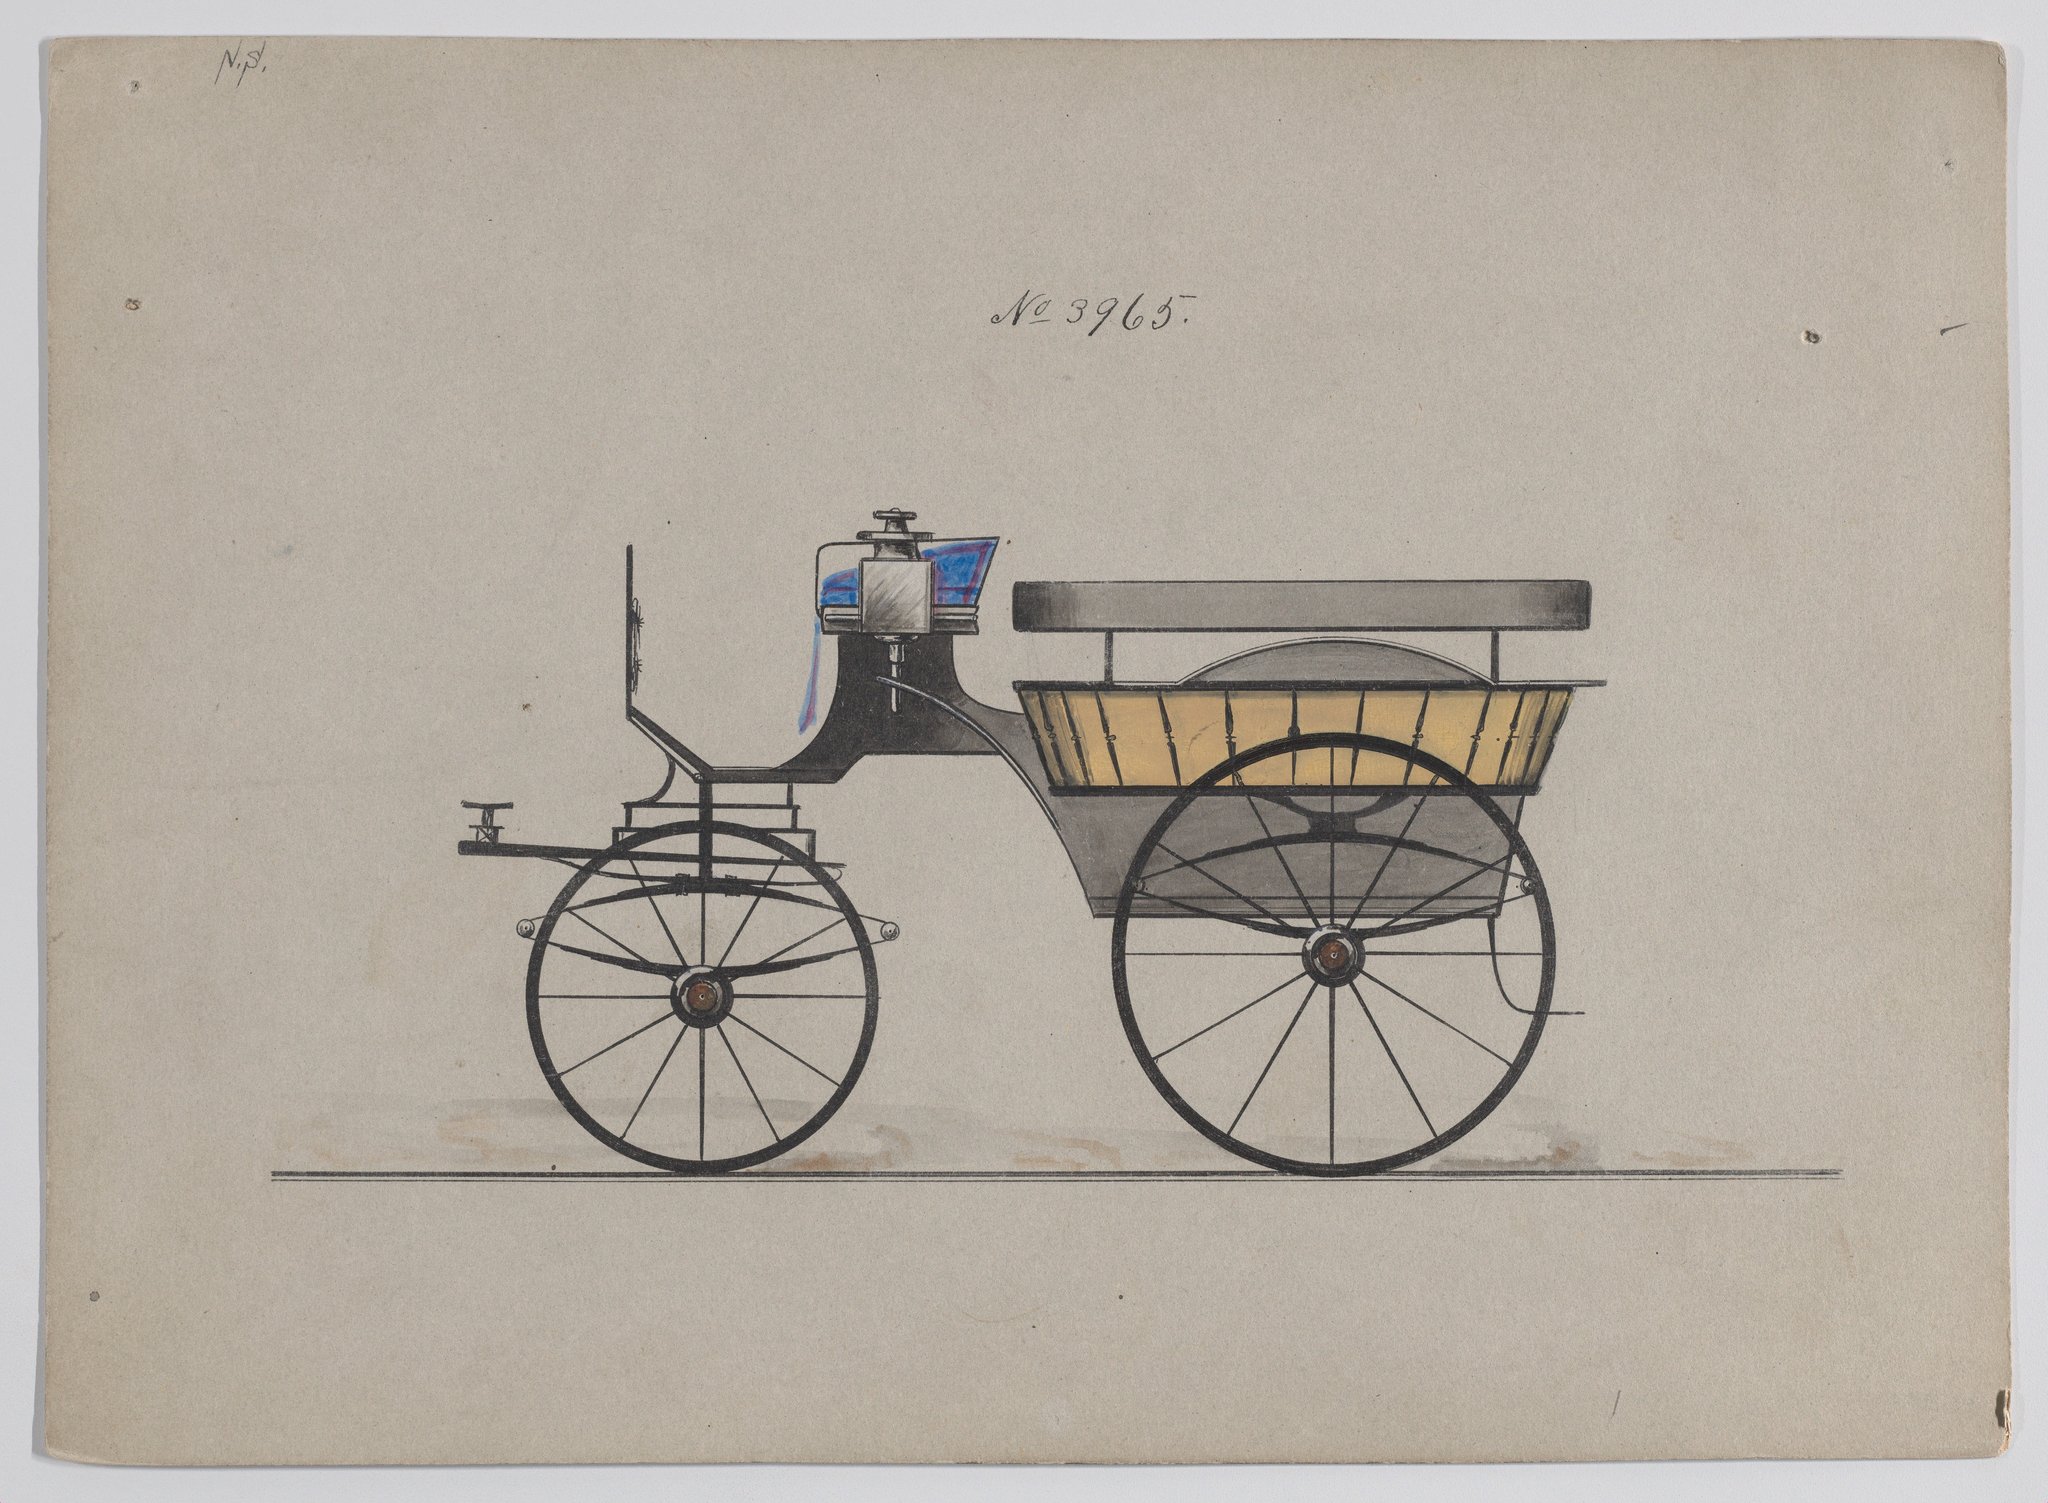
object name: drawing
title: Design for Omnibus or Wagonette, no. 3965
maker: brewster & co.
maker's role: manufacturer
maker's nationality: american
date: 1886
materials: gouache, ink, watercolor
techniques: pen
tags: carriages